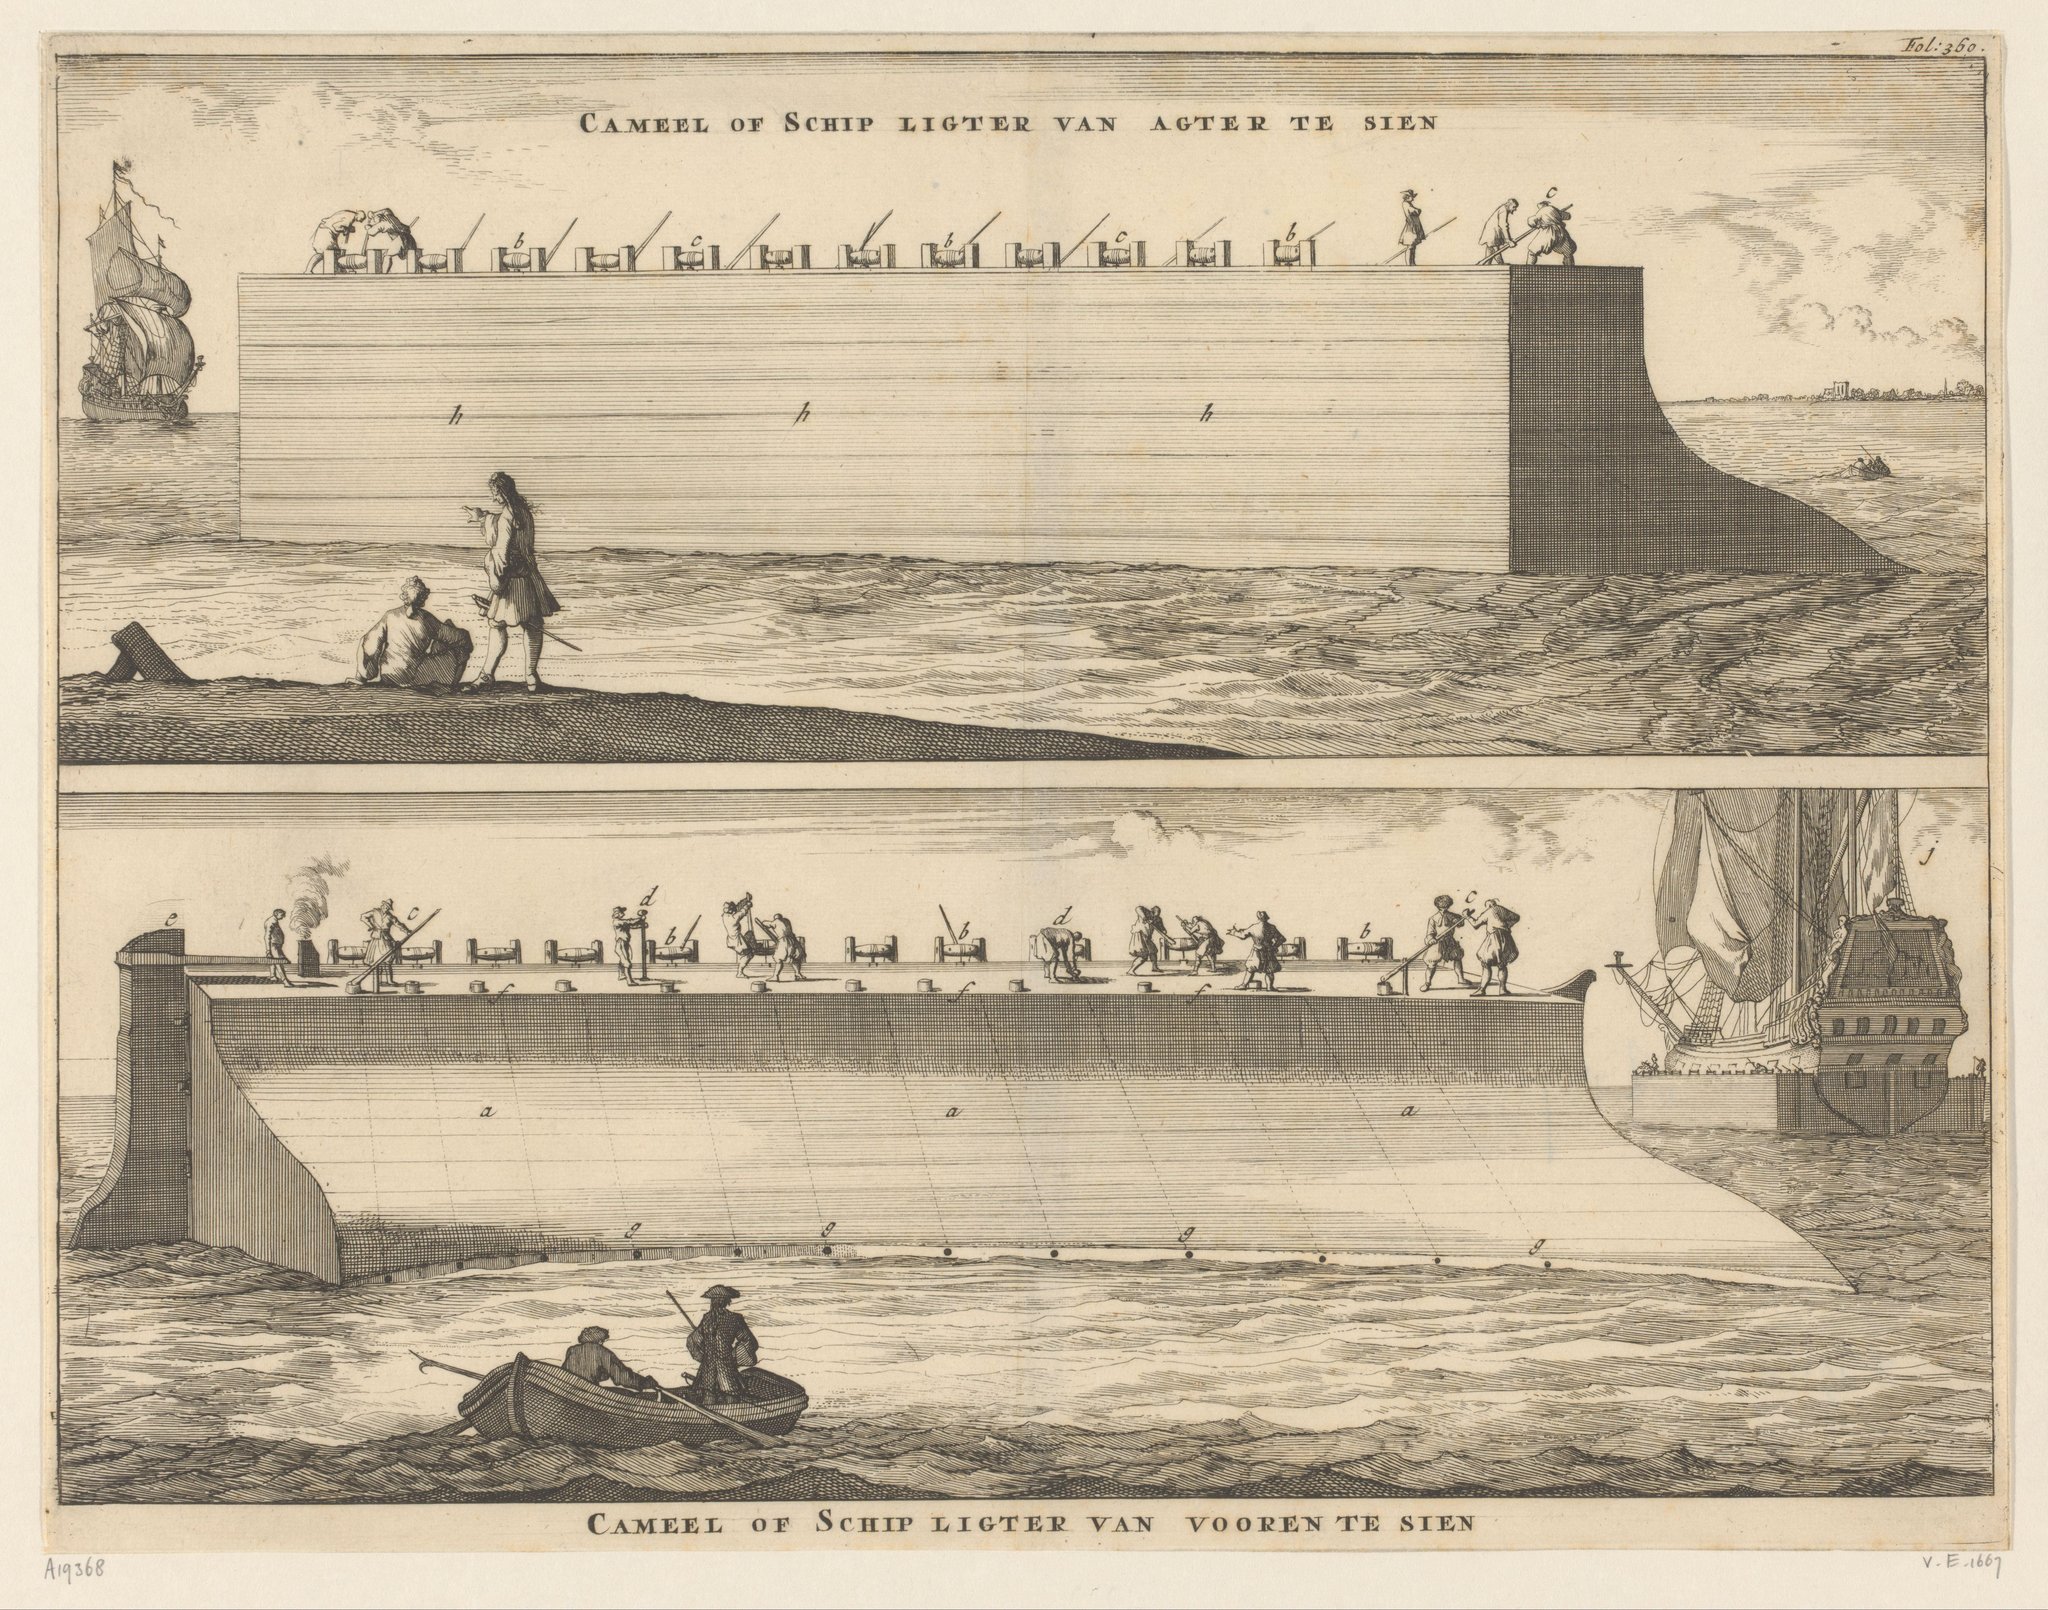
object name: print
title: Scheepskameel van voren en achteren gezien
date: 1697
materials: paper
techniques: etching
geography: amsterdam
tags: ship's camel (device used to raise a ship over a bar), sailing-ship, sailing-boat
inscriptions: collector's mark: Lugt 2228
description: Latere staat van deze prent opgenomen in: Yk, Cornelis van. De Nederlandsche scheepsbouw-konst open gestelt. Amsterdam: Jan Claesz ten Hoorn, 1697.